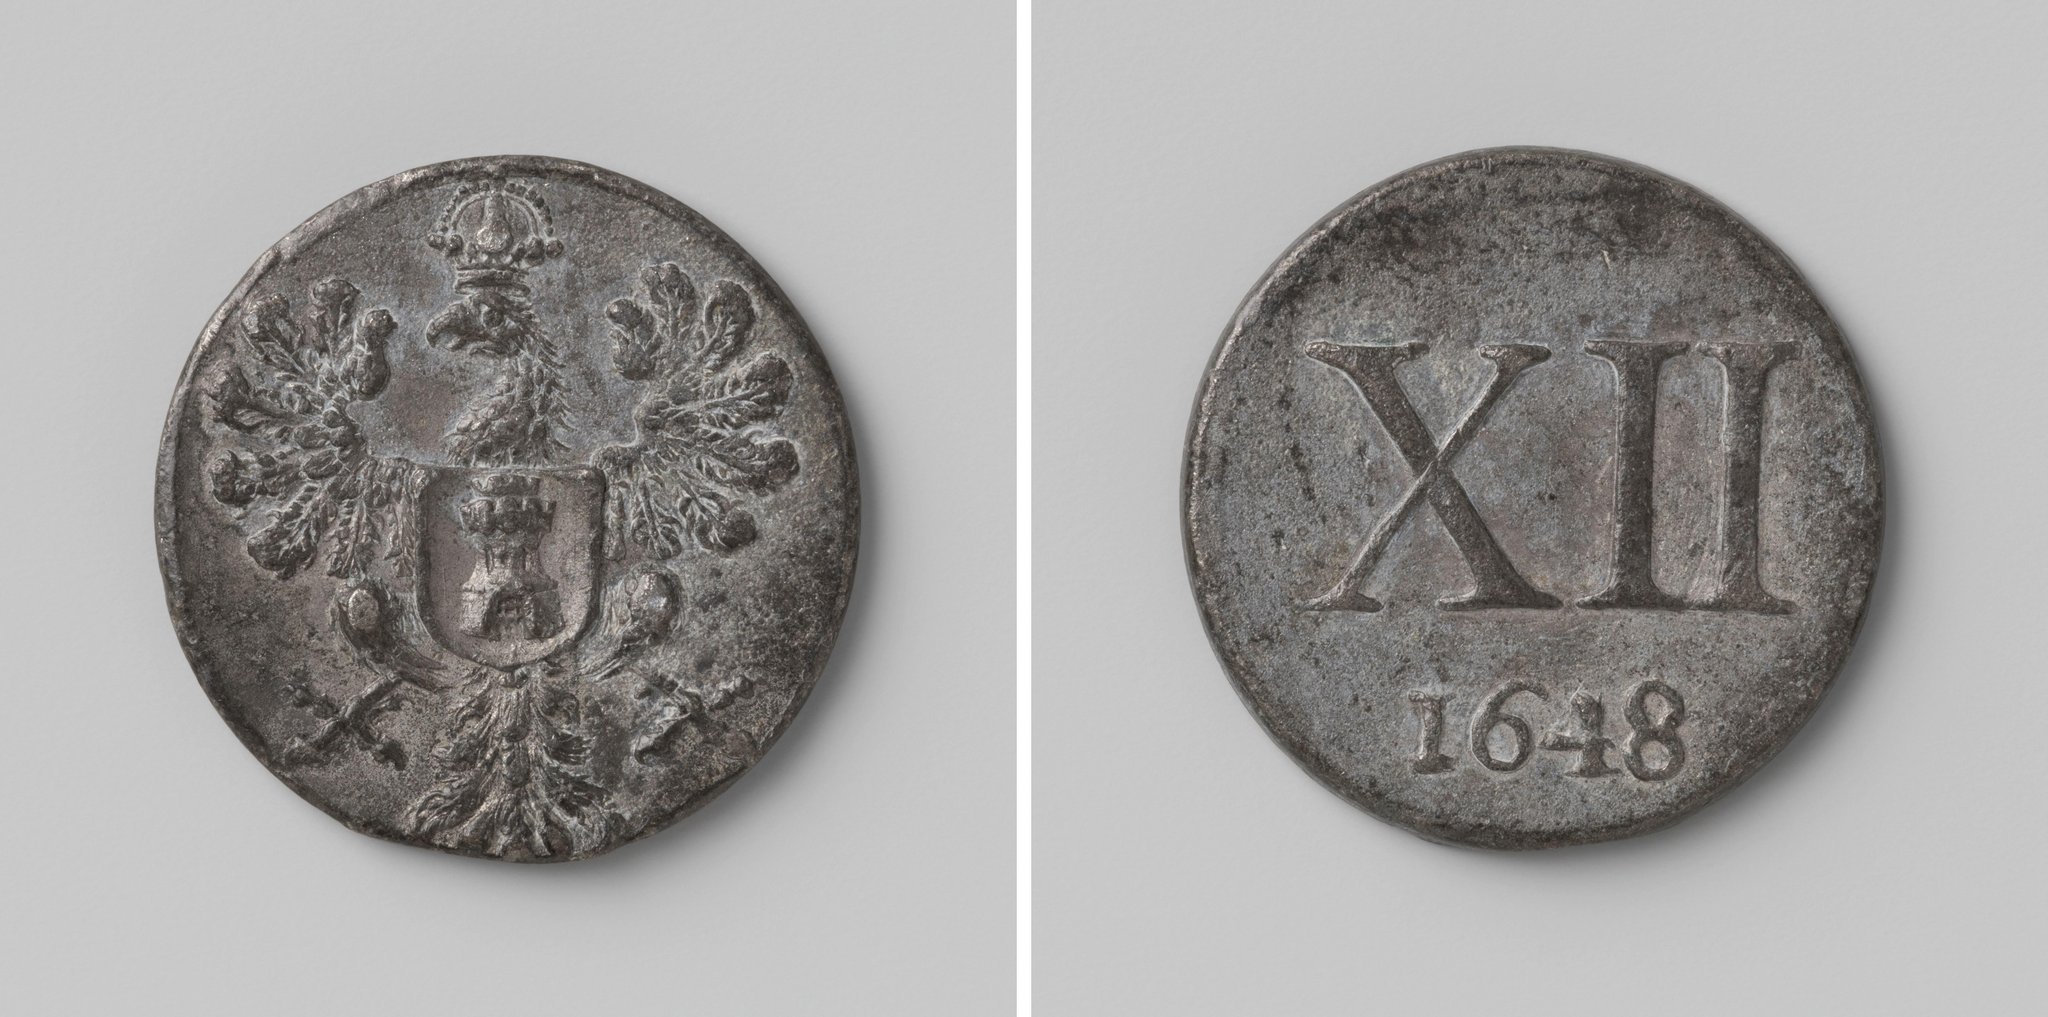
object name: council medal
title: Vroedschap van Middelburg, penning ter waarde van 12 stuivers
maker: johannes looff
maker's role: die cutter, draughtsman, print maker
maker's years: -1651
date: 1648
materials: tin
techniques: striking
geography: middelburg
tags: middelburg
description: Tinnen penning. Voorzijde: gekroonde arend met uitgespreide vleugels en wapenschild voor borst. Keerzijde: Romeinse cijfer XII boven jaartal